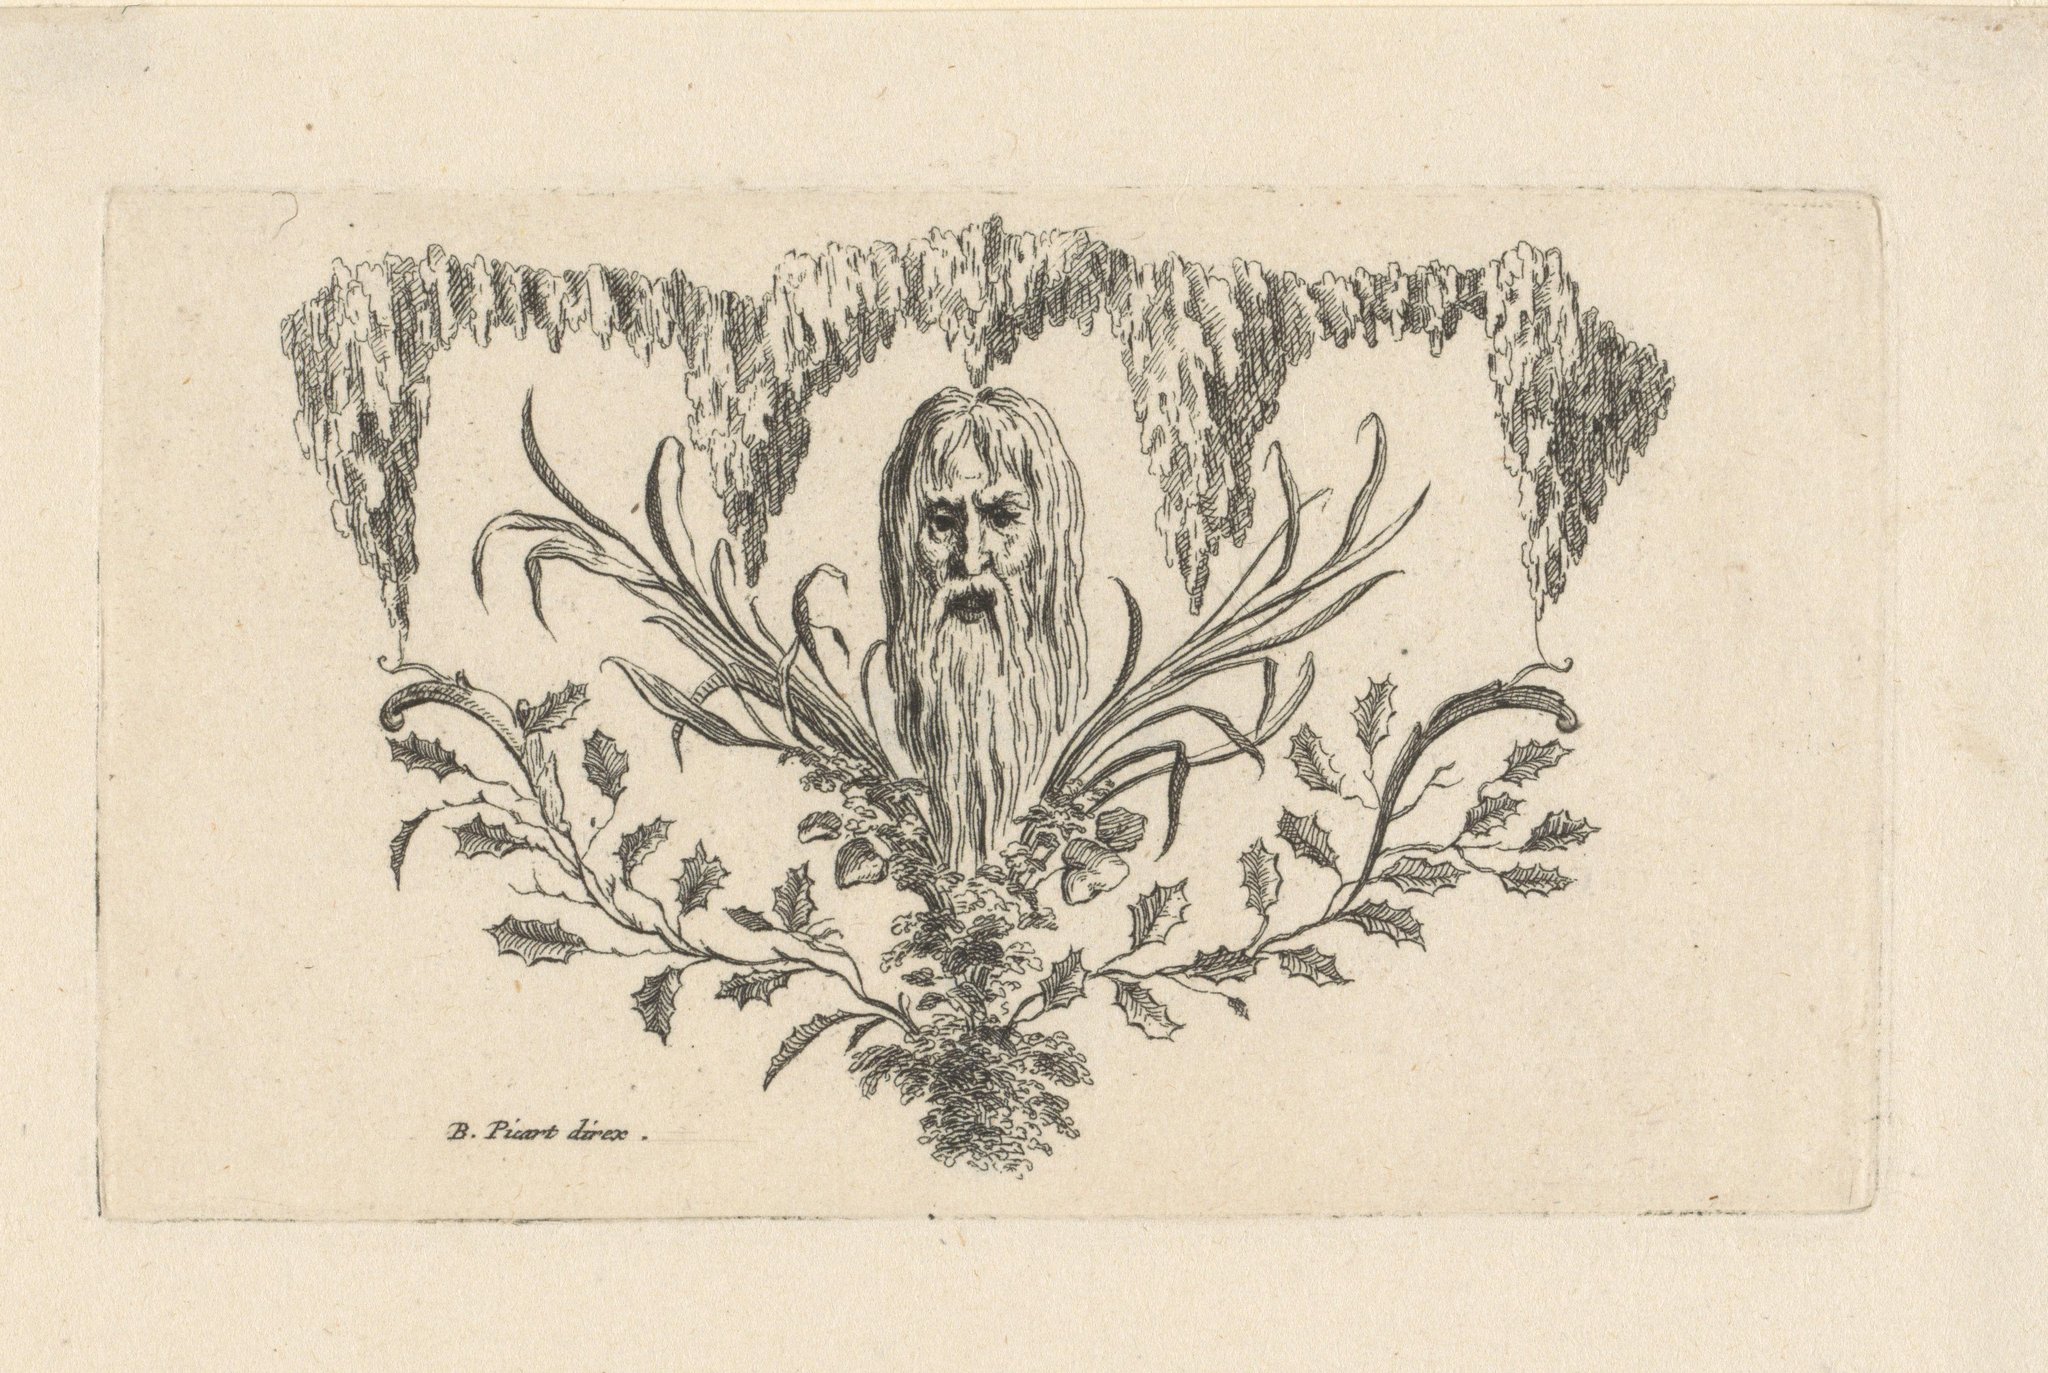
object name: ornament print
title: Vignet met mannenkop met lange baard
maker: bernard picart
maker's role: draughtsman, print maker, publisher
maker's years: 1673-1733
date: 1683-1733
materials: paper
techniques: engraving, etching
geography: amsterdam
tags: ornaments ~ art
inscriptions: collector's mark: Lugt 2233